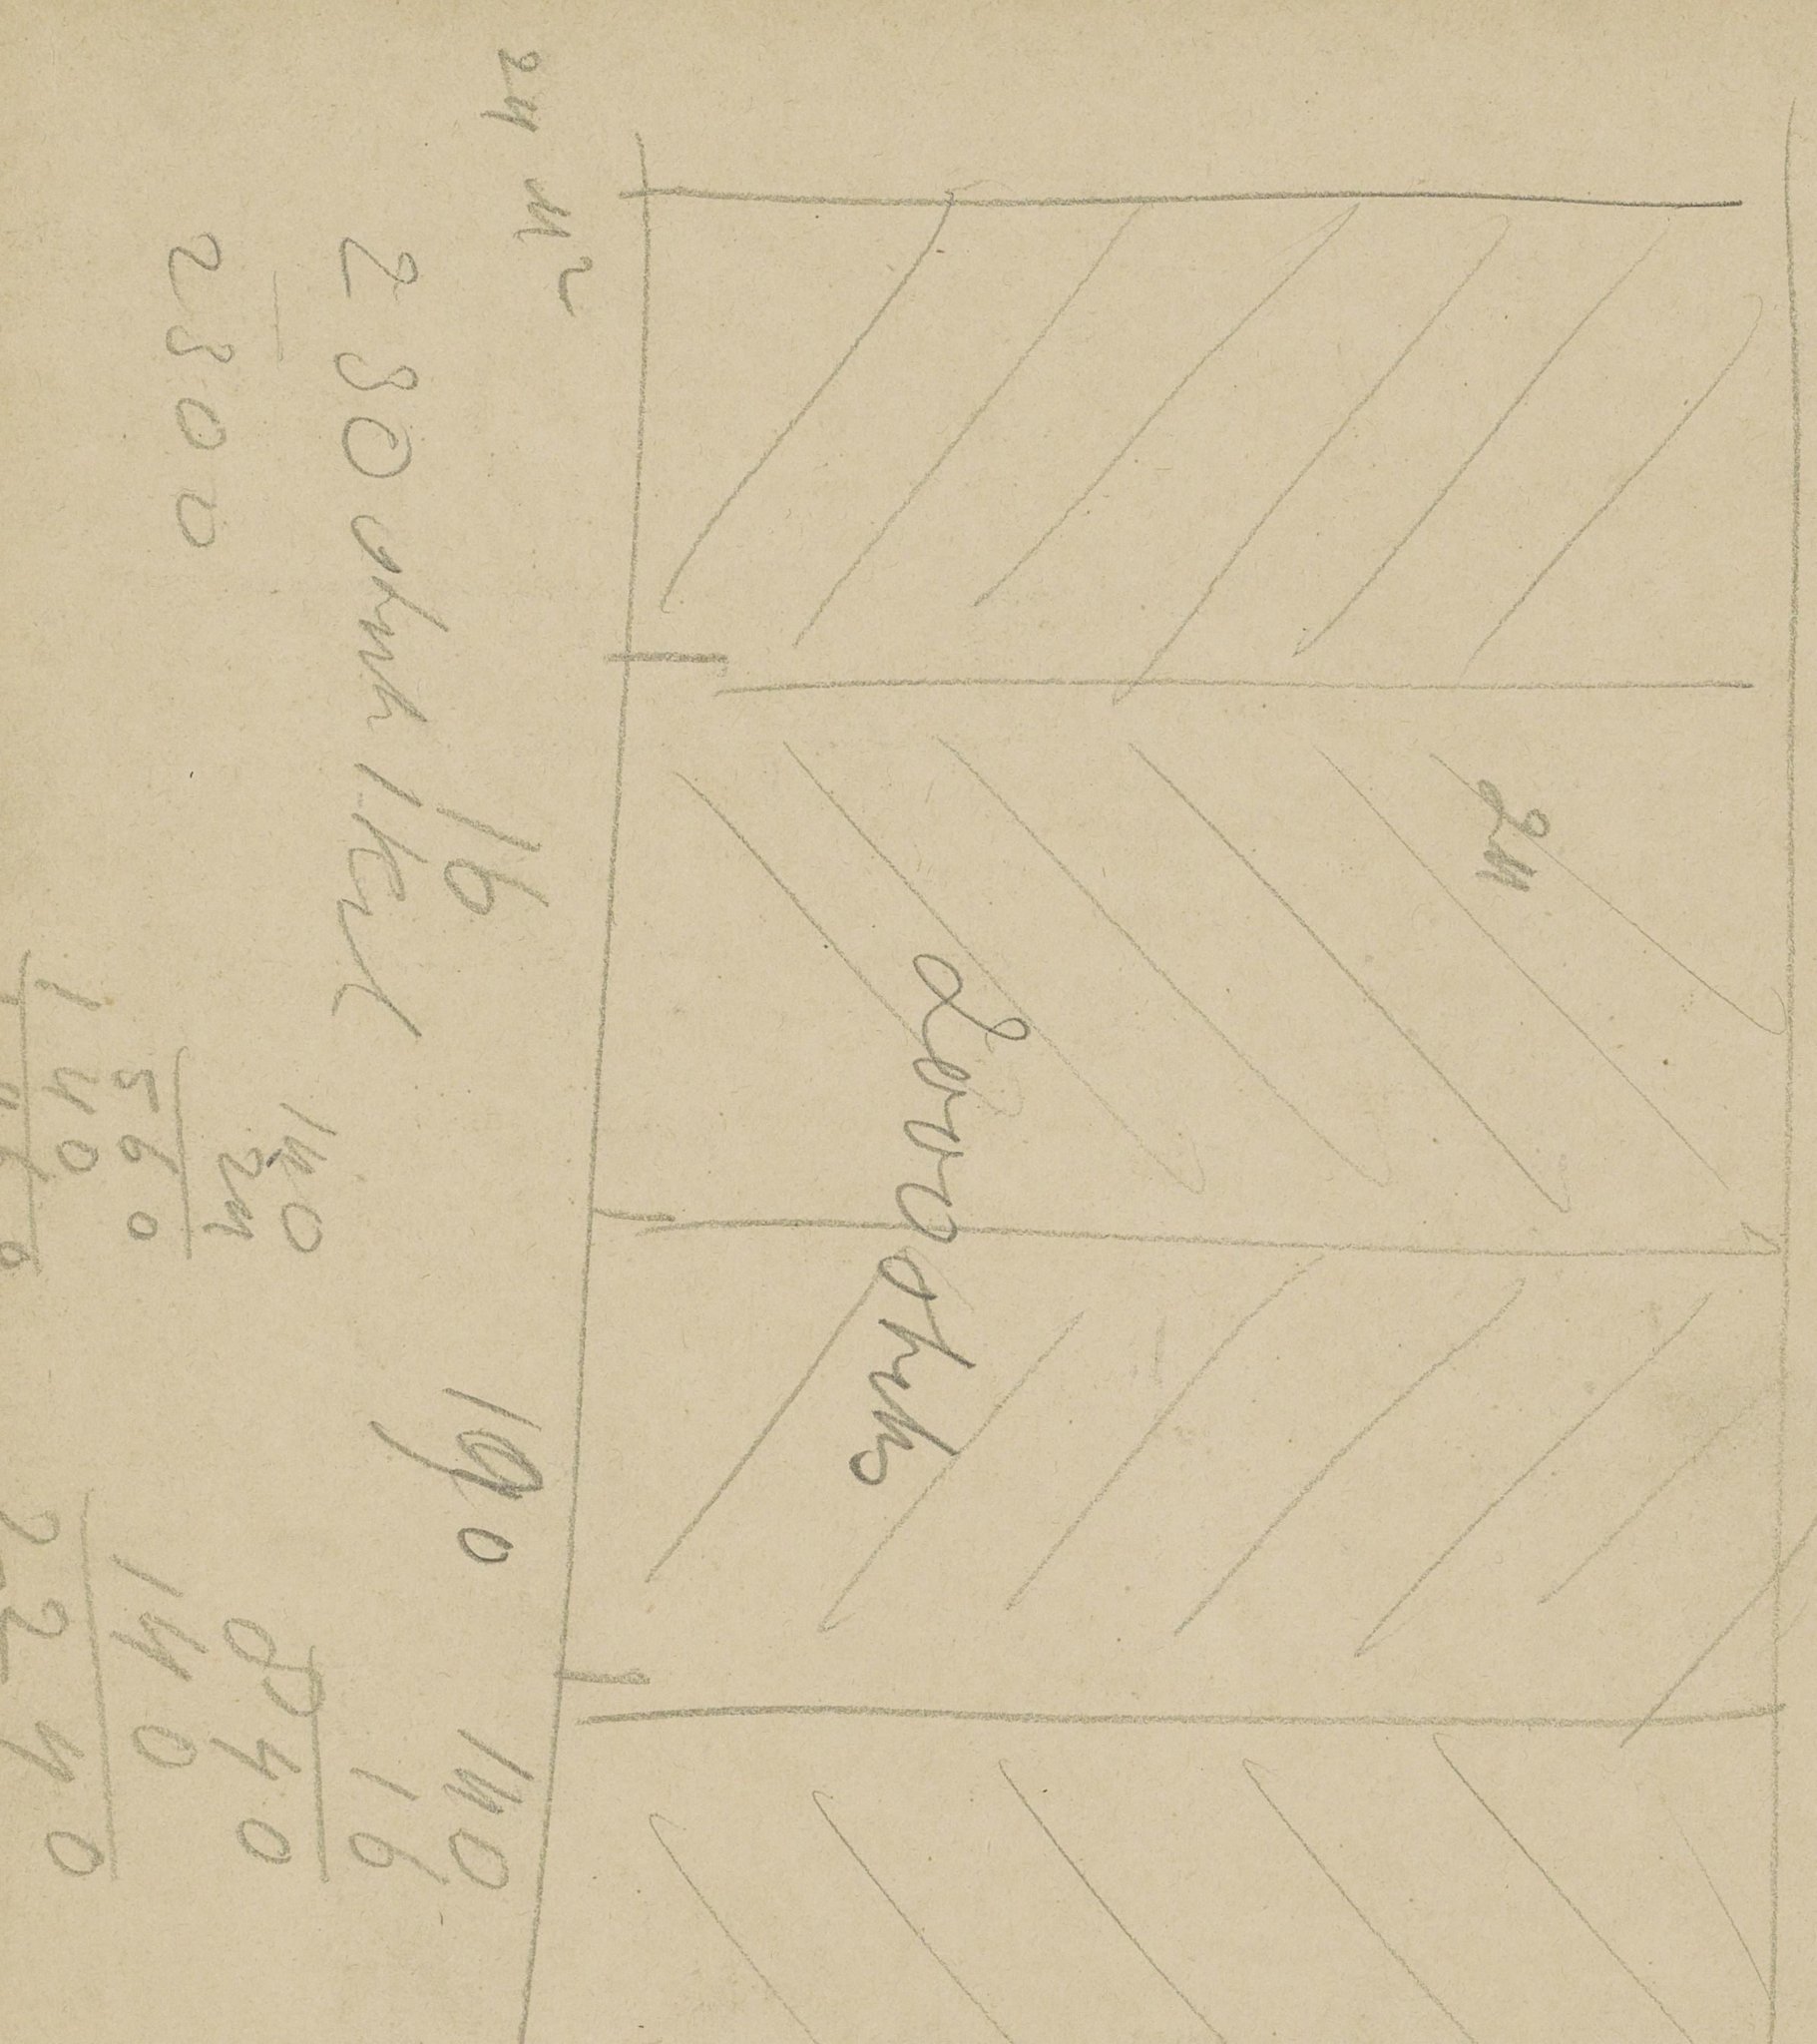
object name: sketchbook leaf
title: Studie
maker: carel adolph lion cachet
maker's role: draughtsman, print maker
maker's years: 1864-1945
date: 1905-1906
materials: paper, pencil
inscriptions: annotation: ‘[...]’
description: Mogelijk een scherm of hek. Blad 14 verso uit een schetsboek met 30 bladen.